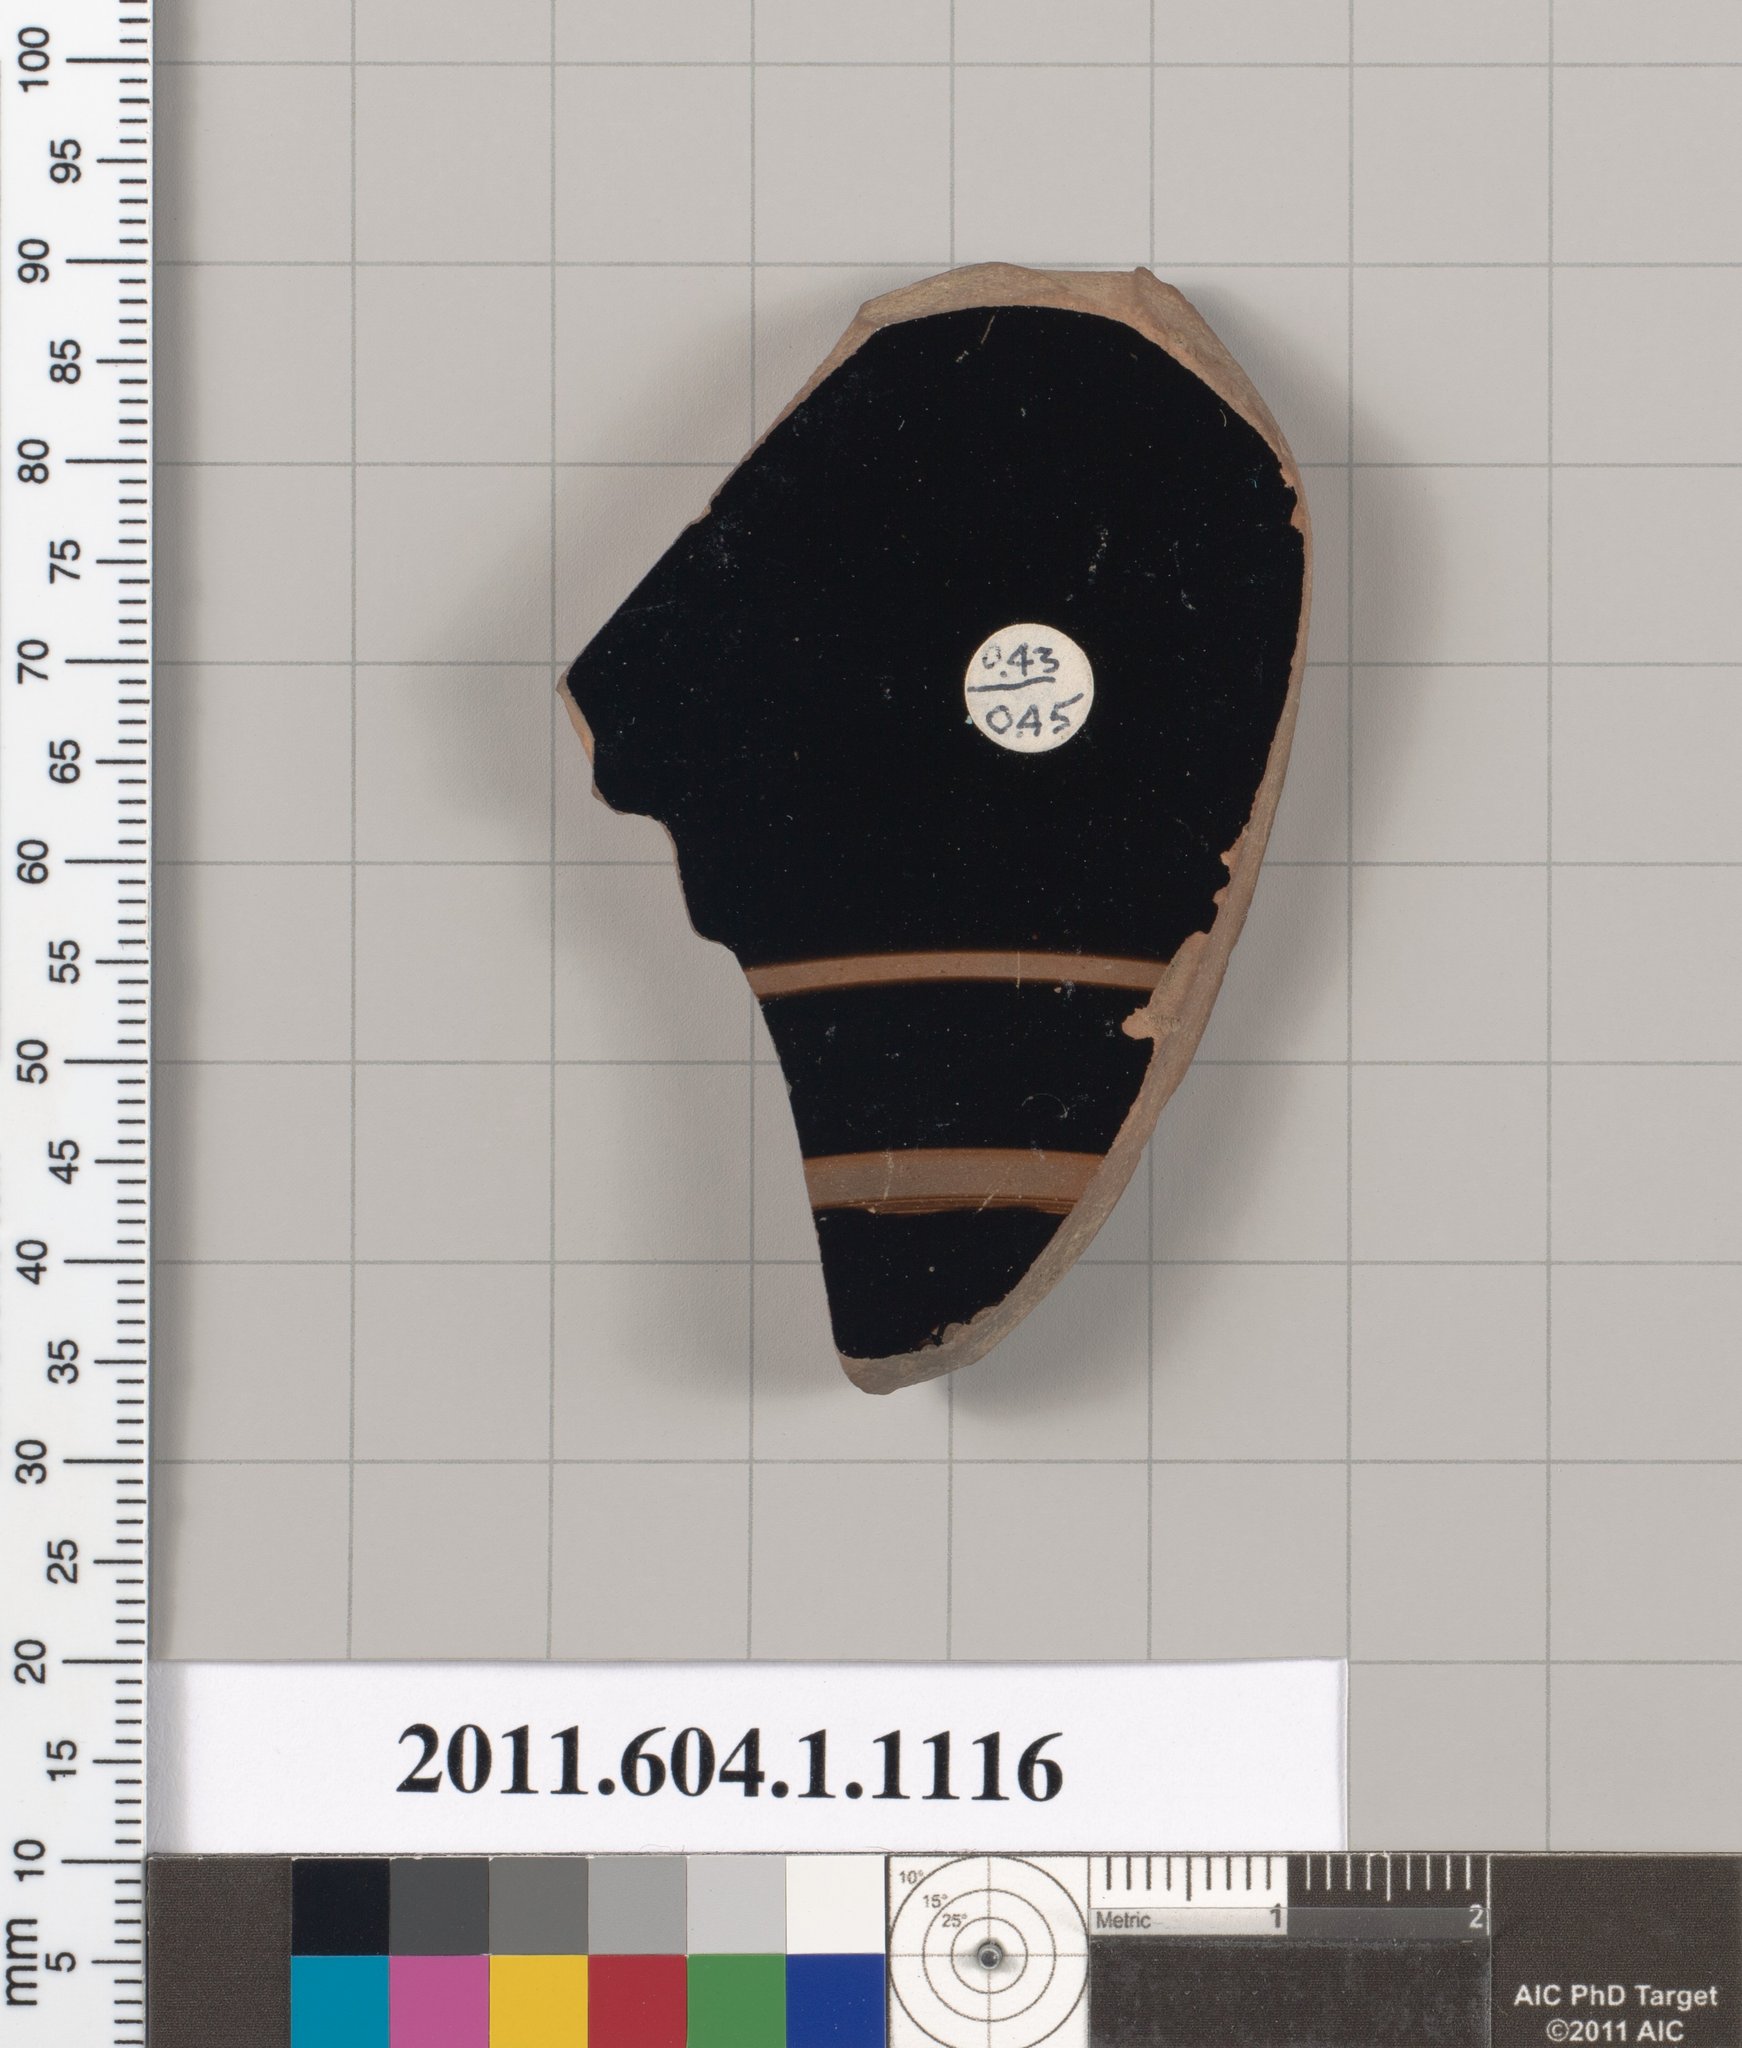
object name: kylix fragment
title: Terracotta fragment of a kylix (drinking cup)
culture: greek, attic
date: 520-500 BCE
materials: terracotta